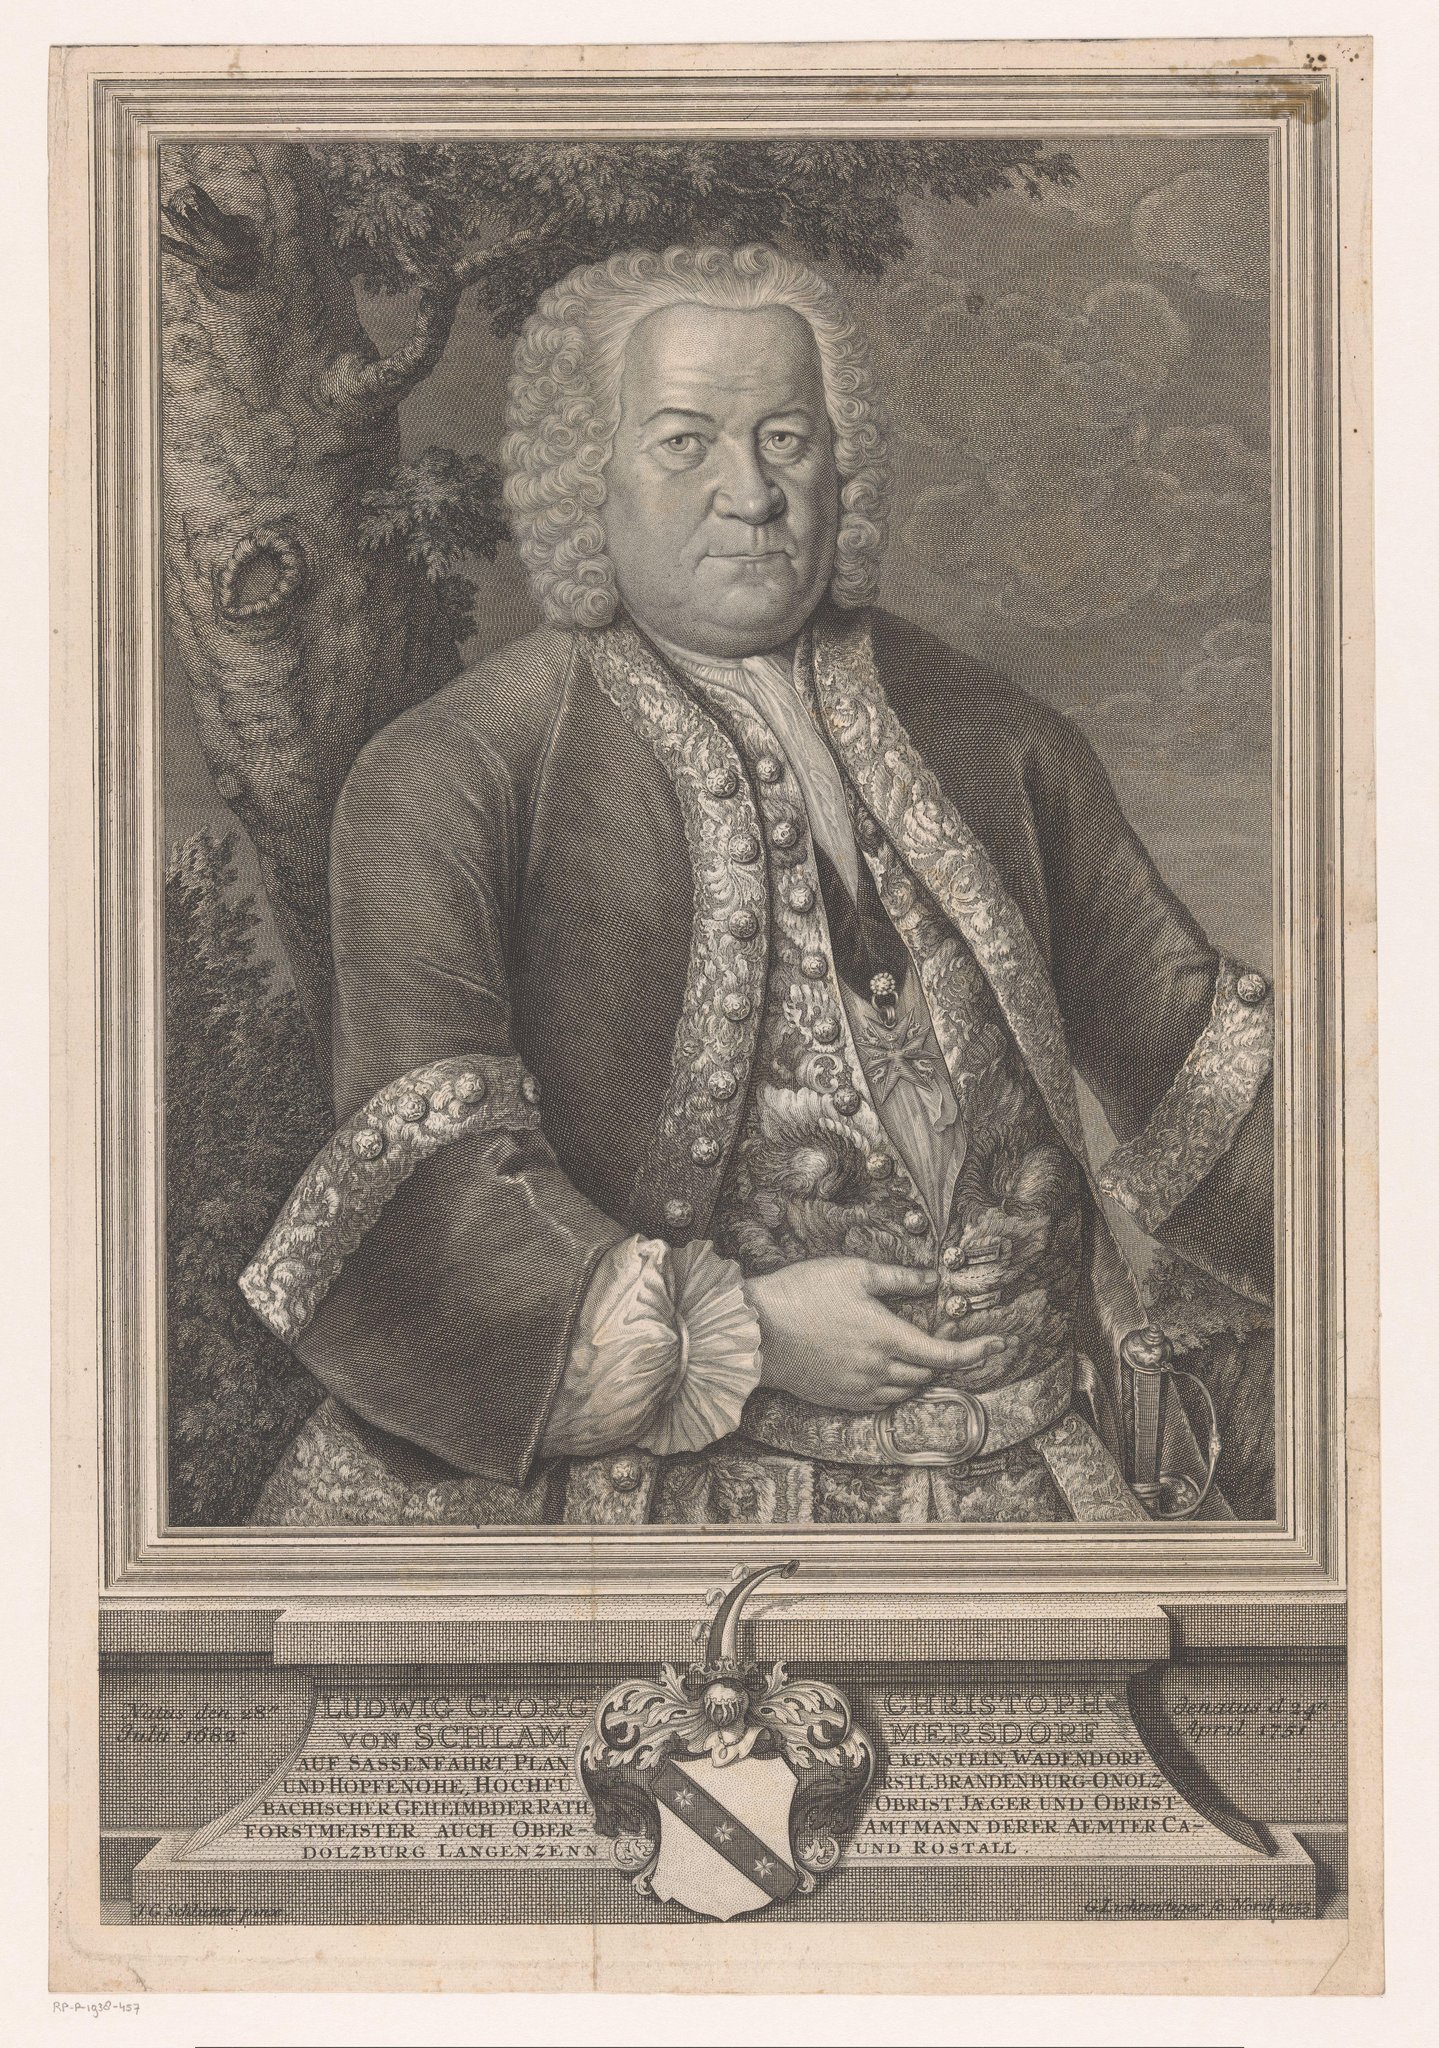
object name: print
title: Portret van Ludwig Georg Christoph von Schlammersdorf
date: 1753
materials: paper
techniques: engraving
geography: nuremberg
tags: historical persons, armorial bearing, heraldry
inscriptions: collector's mark: Lugt 2228